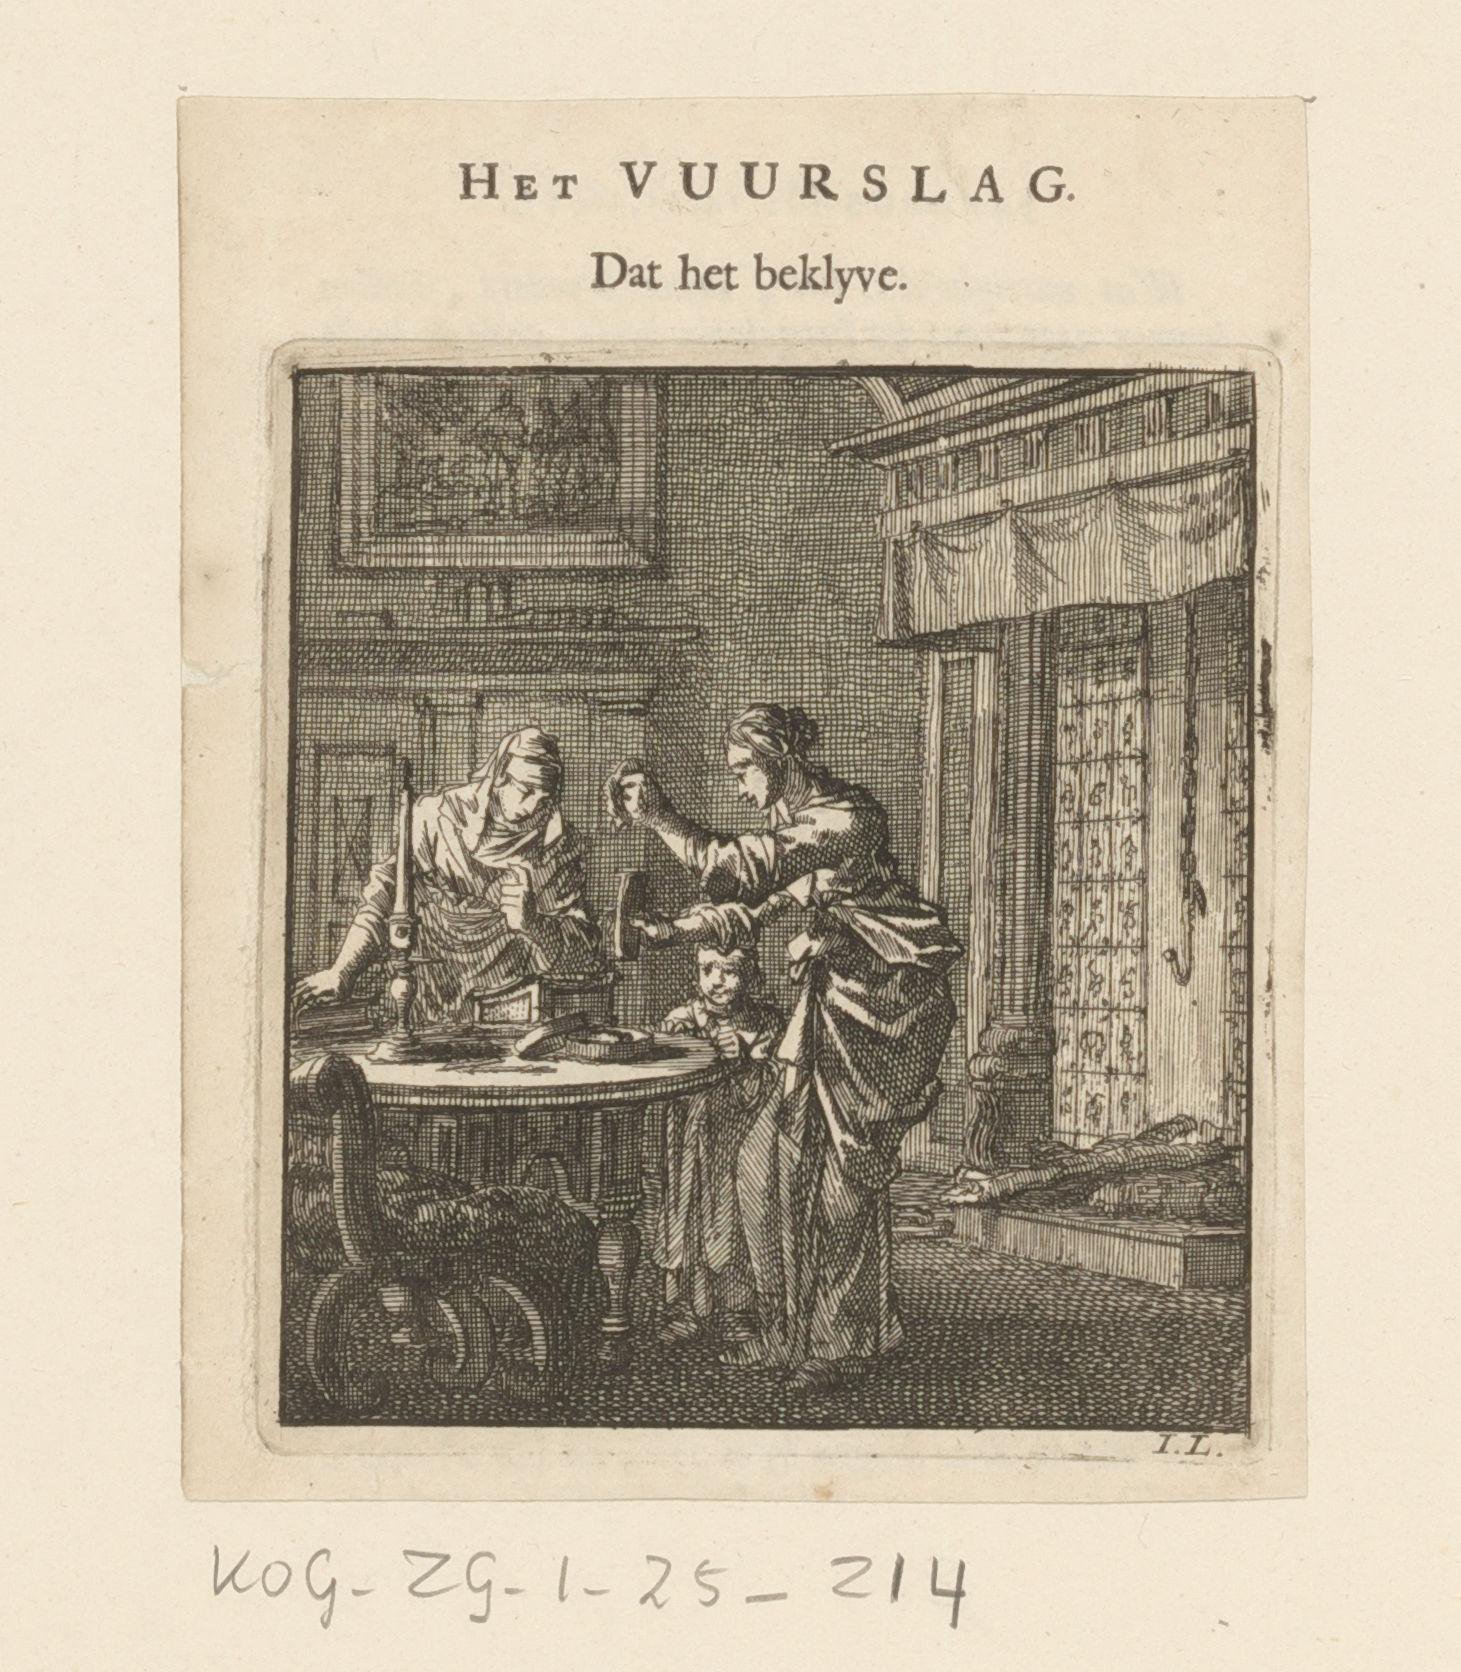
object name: book illustration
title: Het Vuurslag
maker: jan luyken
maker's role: draughtsman, print maker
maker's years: 1649-1712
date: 1711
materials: paper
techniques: etching, letterpress printing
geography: amsterdam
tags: chimney, kinds of non-precious stone: flint, picture, painting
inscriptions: stamp, collector's mark: Lugt 1641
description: Prent uit: Luyken, Jan. Het leerzaam huisraad, vertoond in vyftig konstige figuuren, met godlyke spreuken en stichtelyke verzen. Amsterdam: weduwe Pieter Arentsz. II en Cornelis van der Sys, 1711, p. 42.